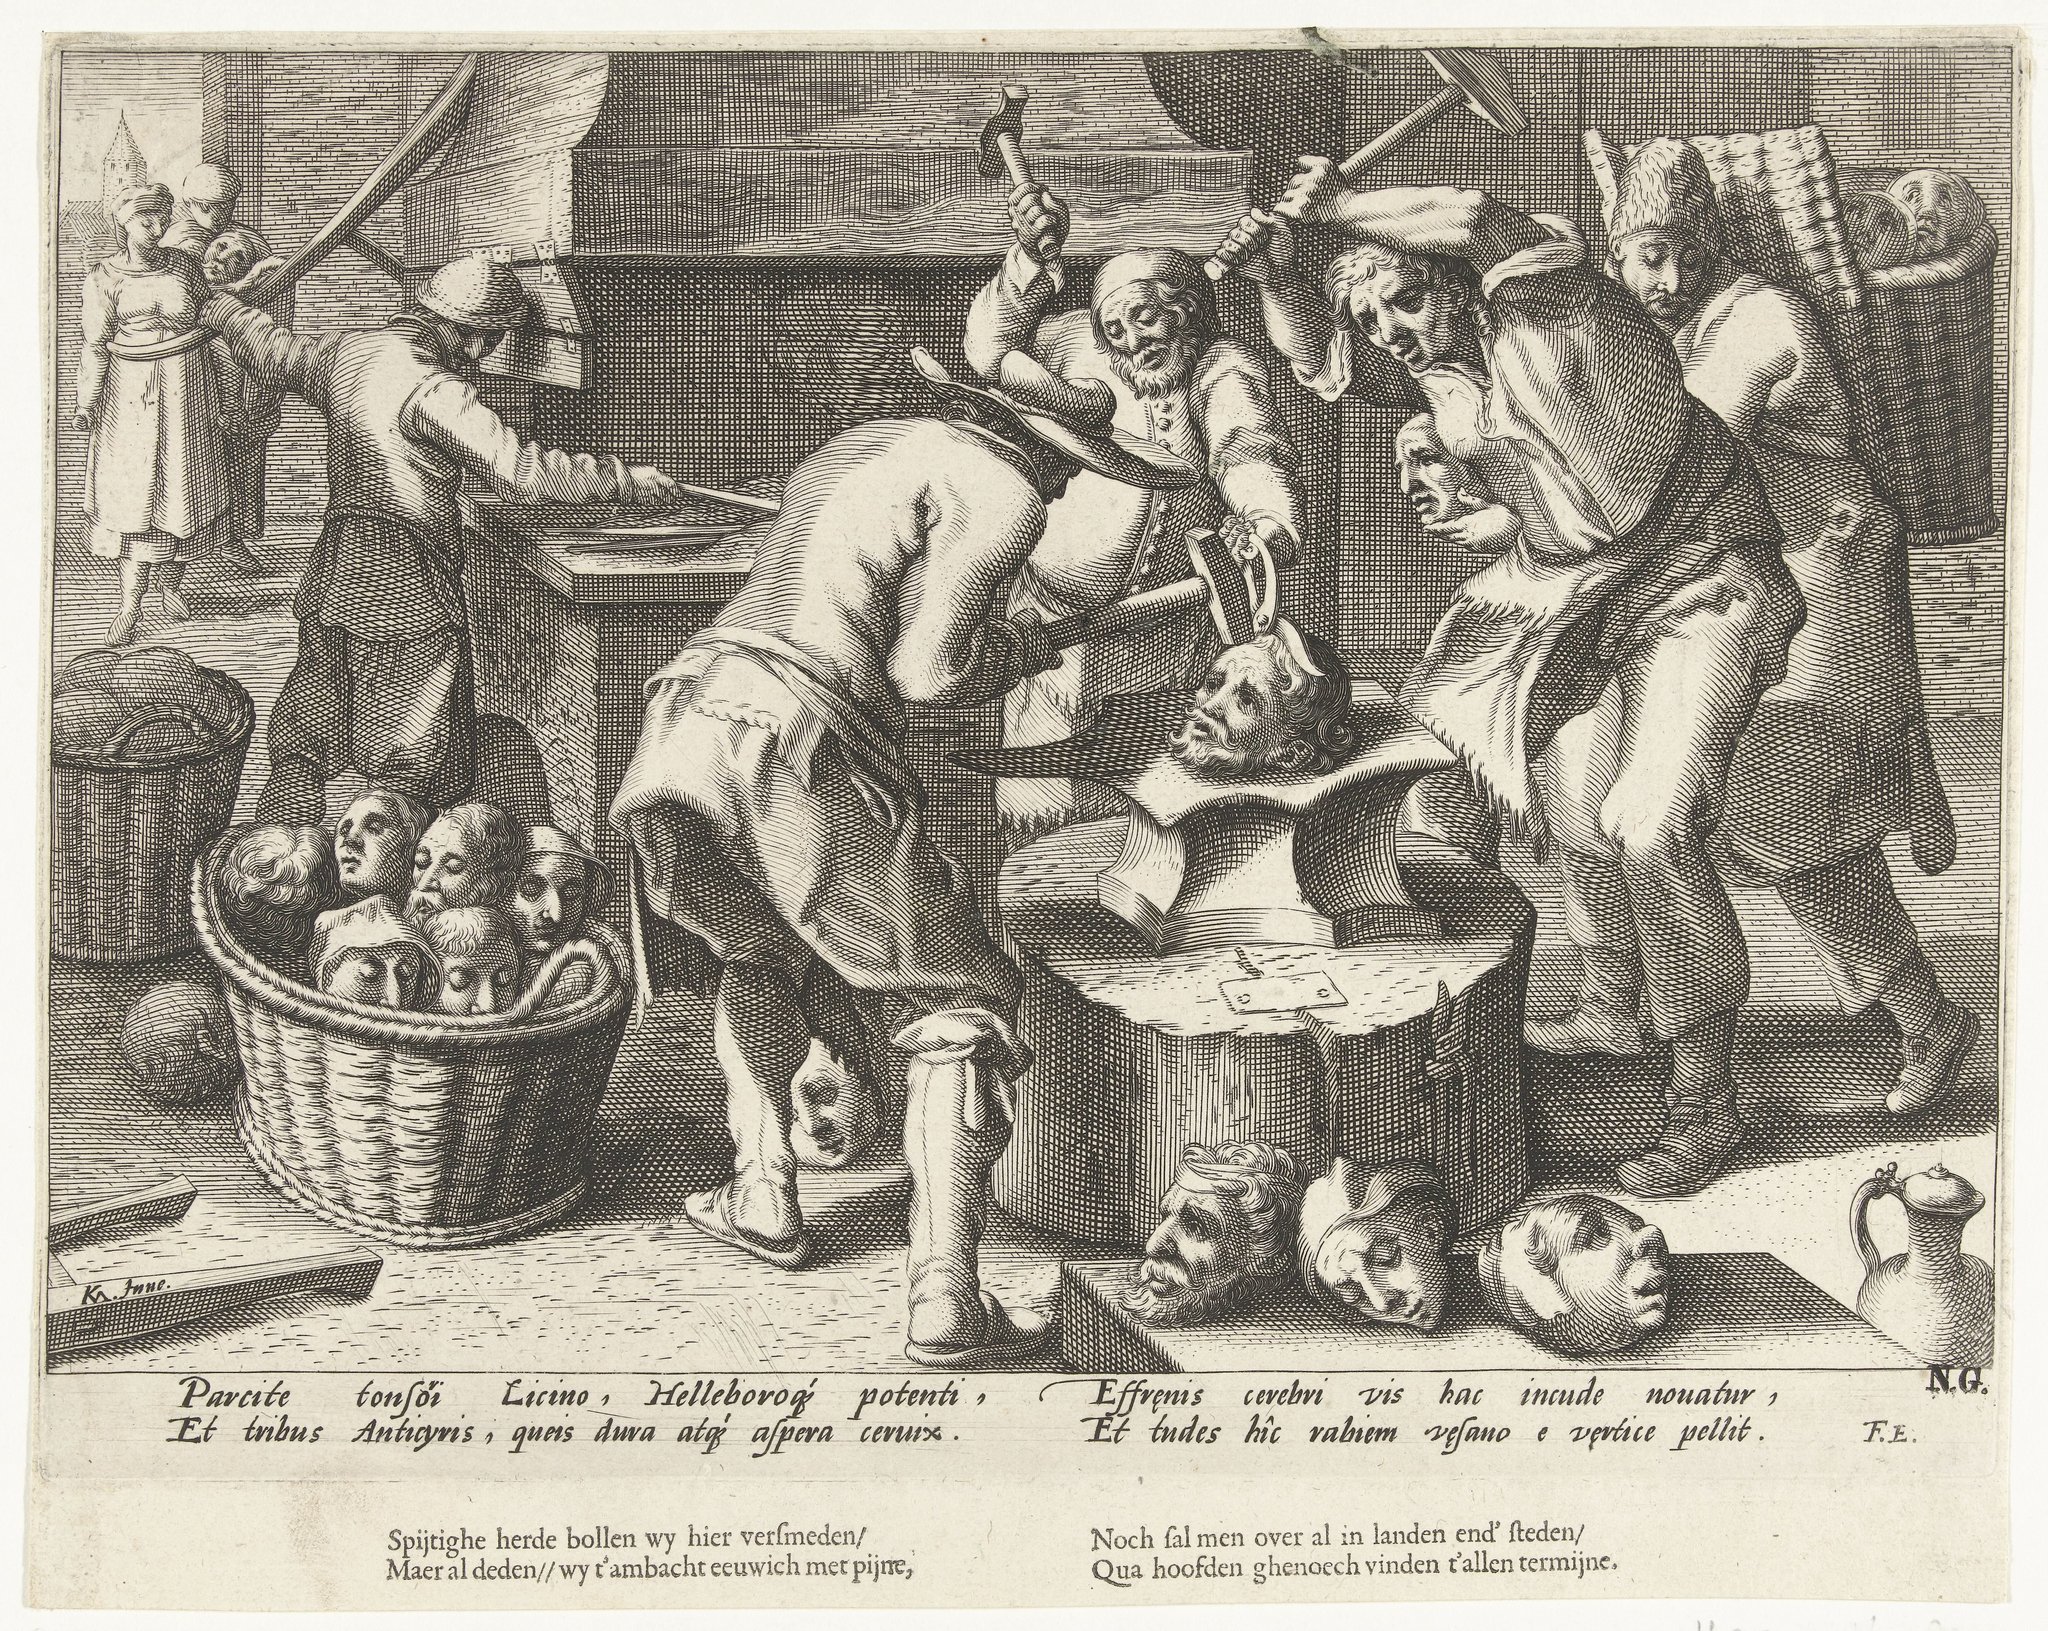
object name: print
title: Smeden van hoofden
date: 1590-1594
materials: paper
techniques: engraving, letterpress printing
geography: haarlem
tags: head (human), abstract ideas and concepts (+ emblematical representation of concept), ways pretending to cure simpletons (folklore), forging (industrial process) (+ variant), obstinacy; 'ostinatione', 'pertinacia' (ripa)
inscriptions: collector's mark: Lugt 2228, collector's mark: Lugt 1967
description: In een smederij worden menselijke hoofden gesmeed. Het zijn "harde koppen" die op een halsstarrige en trotse houding wijzen. De ondeugd van de halsstarrigheid kan alleen worden veranderd door de "spijtige herde bollen" om te smeden. Een mand staat op de grond. Hij zit vol met hoofden. Vier mannen zijn aan het smeden en een vijfde komt met een mand vol hoofden aanlopen.